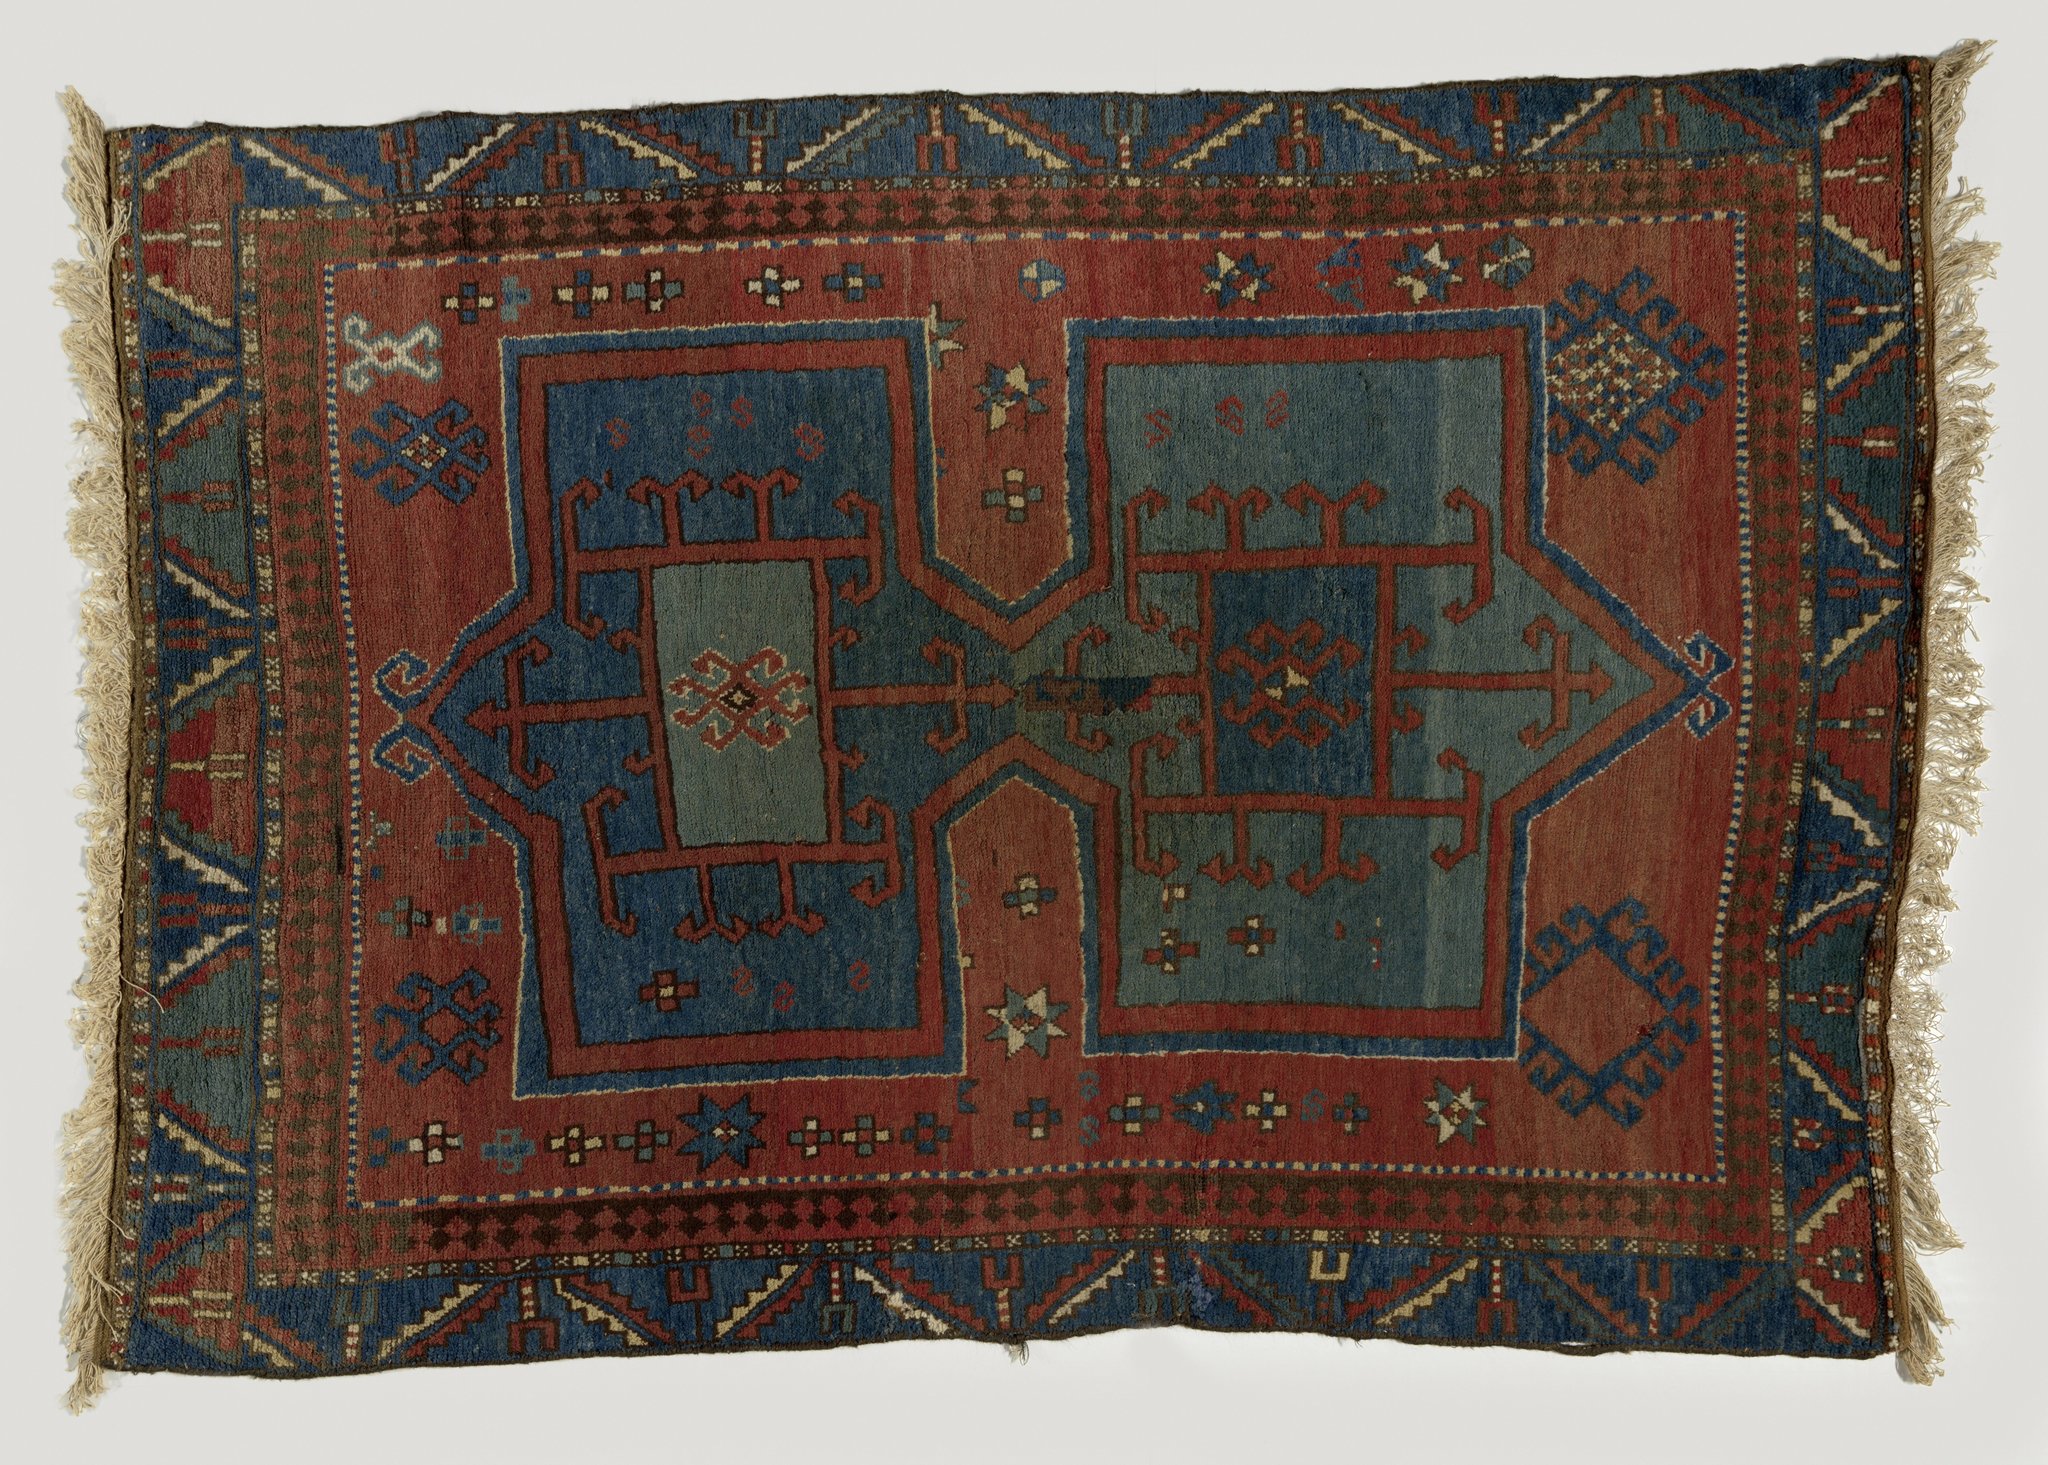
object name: medaillonkleed, medaillontapijt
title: Medaillonkleed, KAZAK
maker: Anonymous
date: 1800-1900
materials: wool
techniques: ghiordes knot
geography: kazakhstan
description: Medaillonkleed, Kazak. Middenveld: donker terrarode fond met een dubbel medaillon in groen/blauw en blauw van een ingesnoerde rechthoek met puntjes aan kop en staart. Daarbinnen bwee blokken met T-haken in ongelijke kleuren, blauw en groen/blauw. Veldvulling van sterretjes. Randen: tweevoudig. De buitenste rand is van ultramarijnblauw met een zaagblad met iets wit en geel en het wijnglasmotief in groen/blauw en rood. De binnenrand is een kantelenrand in bruin en terra.